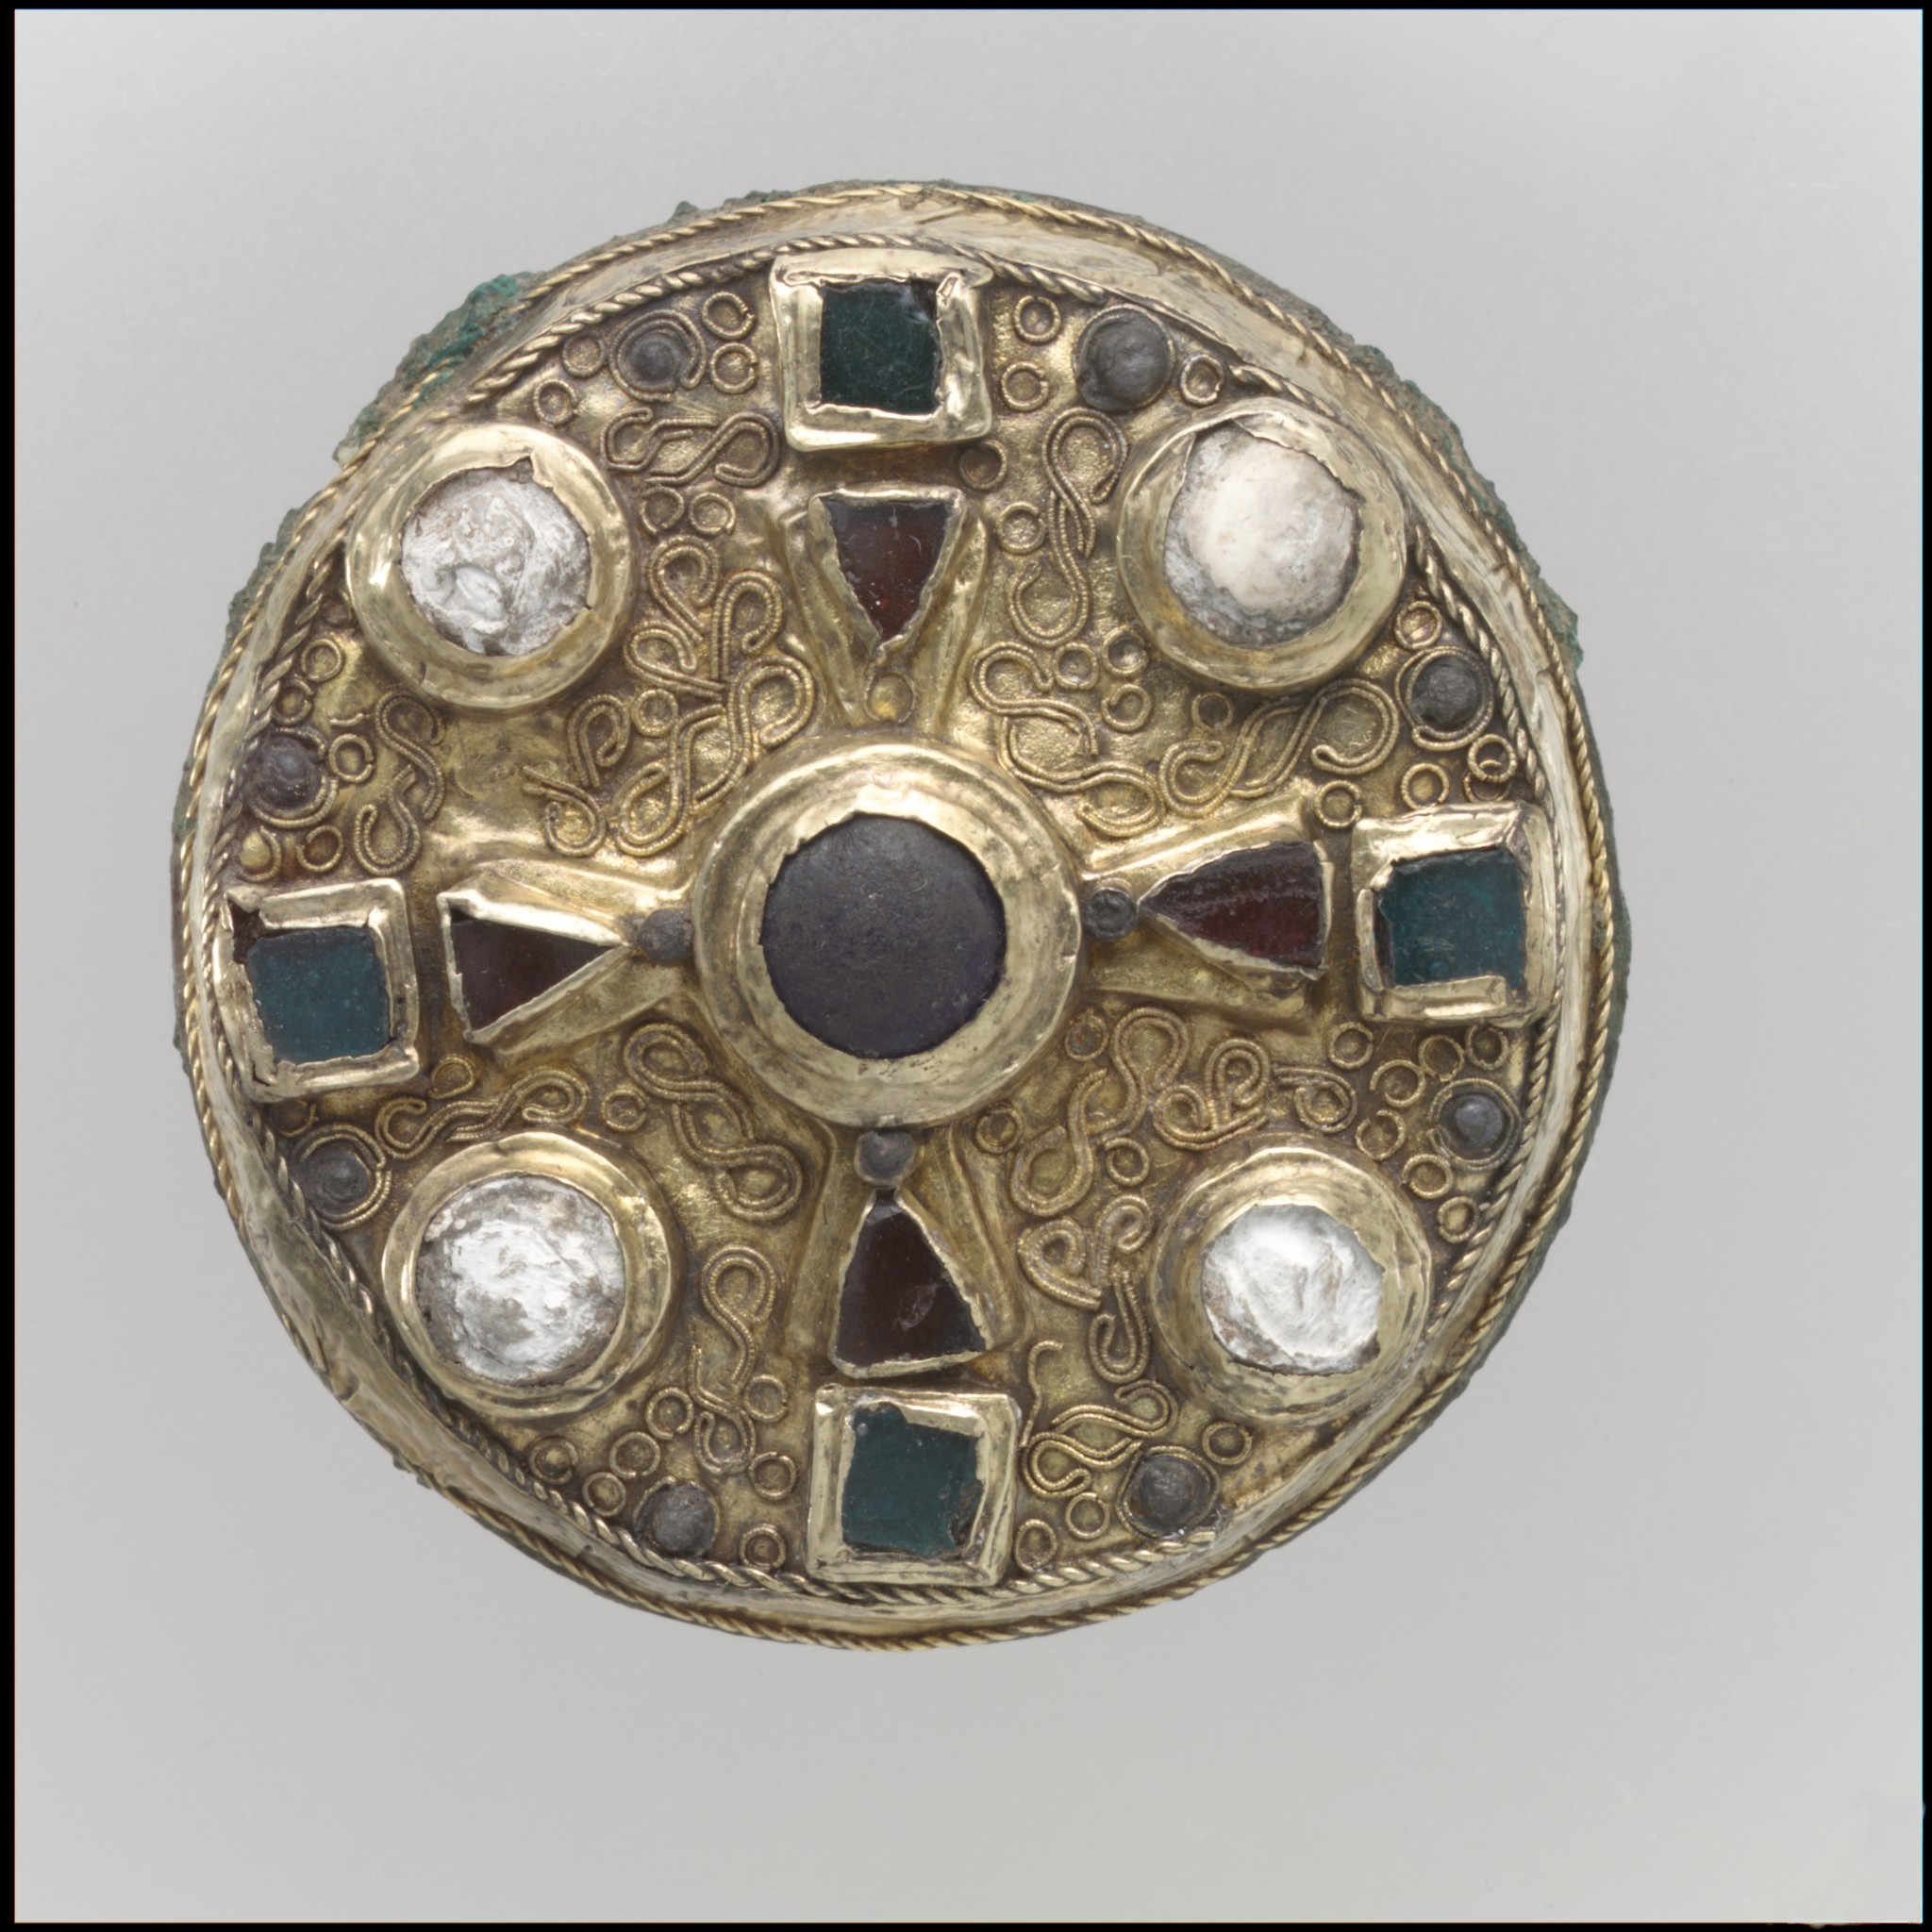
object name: brooch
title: Disk Brooch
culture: frankish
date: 667-700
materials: copper alloy, gemstone, glass, gold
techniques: inlay